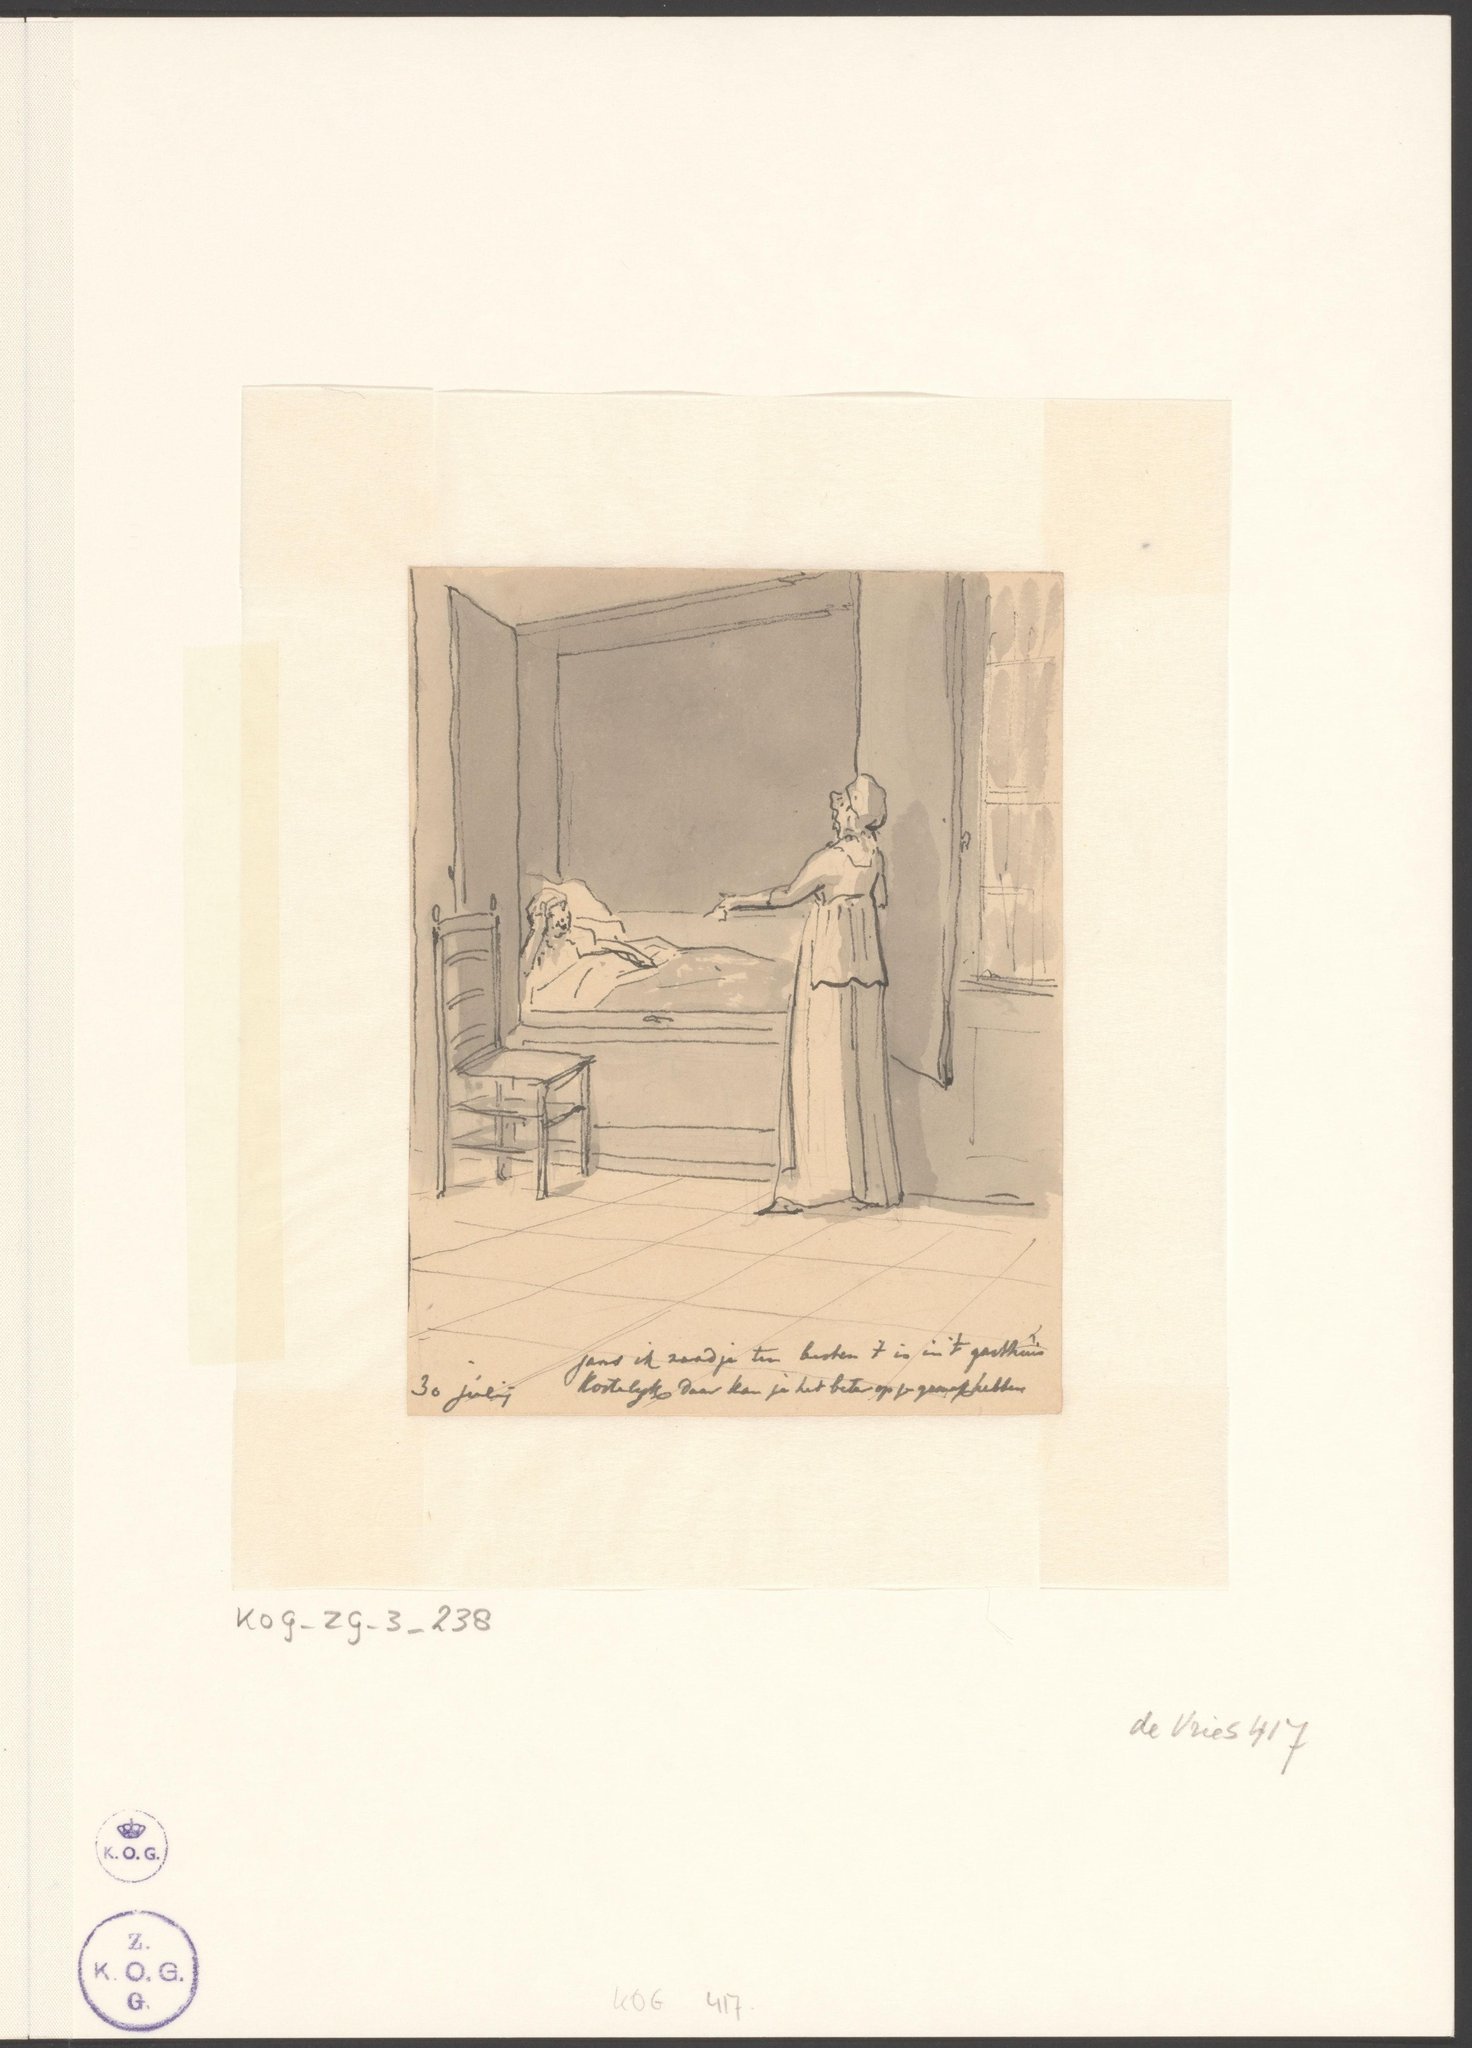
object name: drawing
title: Johanna Geertruy van Dietren op haar ziekbed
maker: christiaan andriessen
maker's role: draughtsman, print maker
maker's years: 1775-1846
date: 1805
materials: ink, paper, pencil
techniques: brush, pen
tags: sick-bed, maid ~ house personnel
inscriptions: inscription: ‘30 julij jans ik raad je ten besten t is in 't gasthuis kostelijk daar kan je he bete op je ..... hebben’, signature: ‘J Andriessen’, collector's mark: Lugt 1641, collector's mark: Lugt 1641a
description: Moeder Andriessen raadt de zieke dienstbode Jans aan naar het Gasthuis te gaan. Johanna Geertruy van Dietren, zoals Jans voluit heette, overleed op 2 augustus.